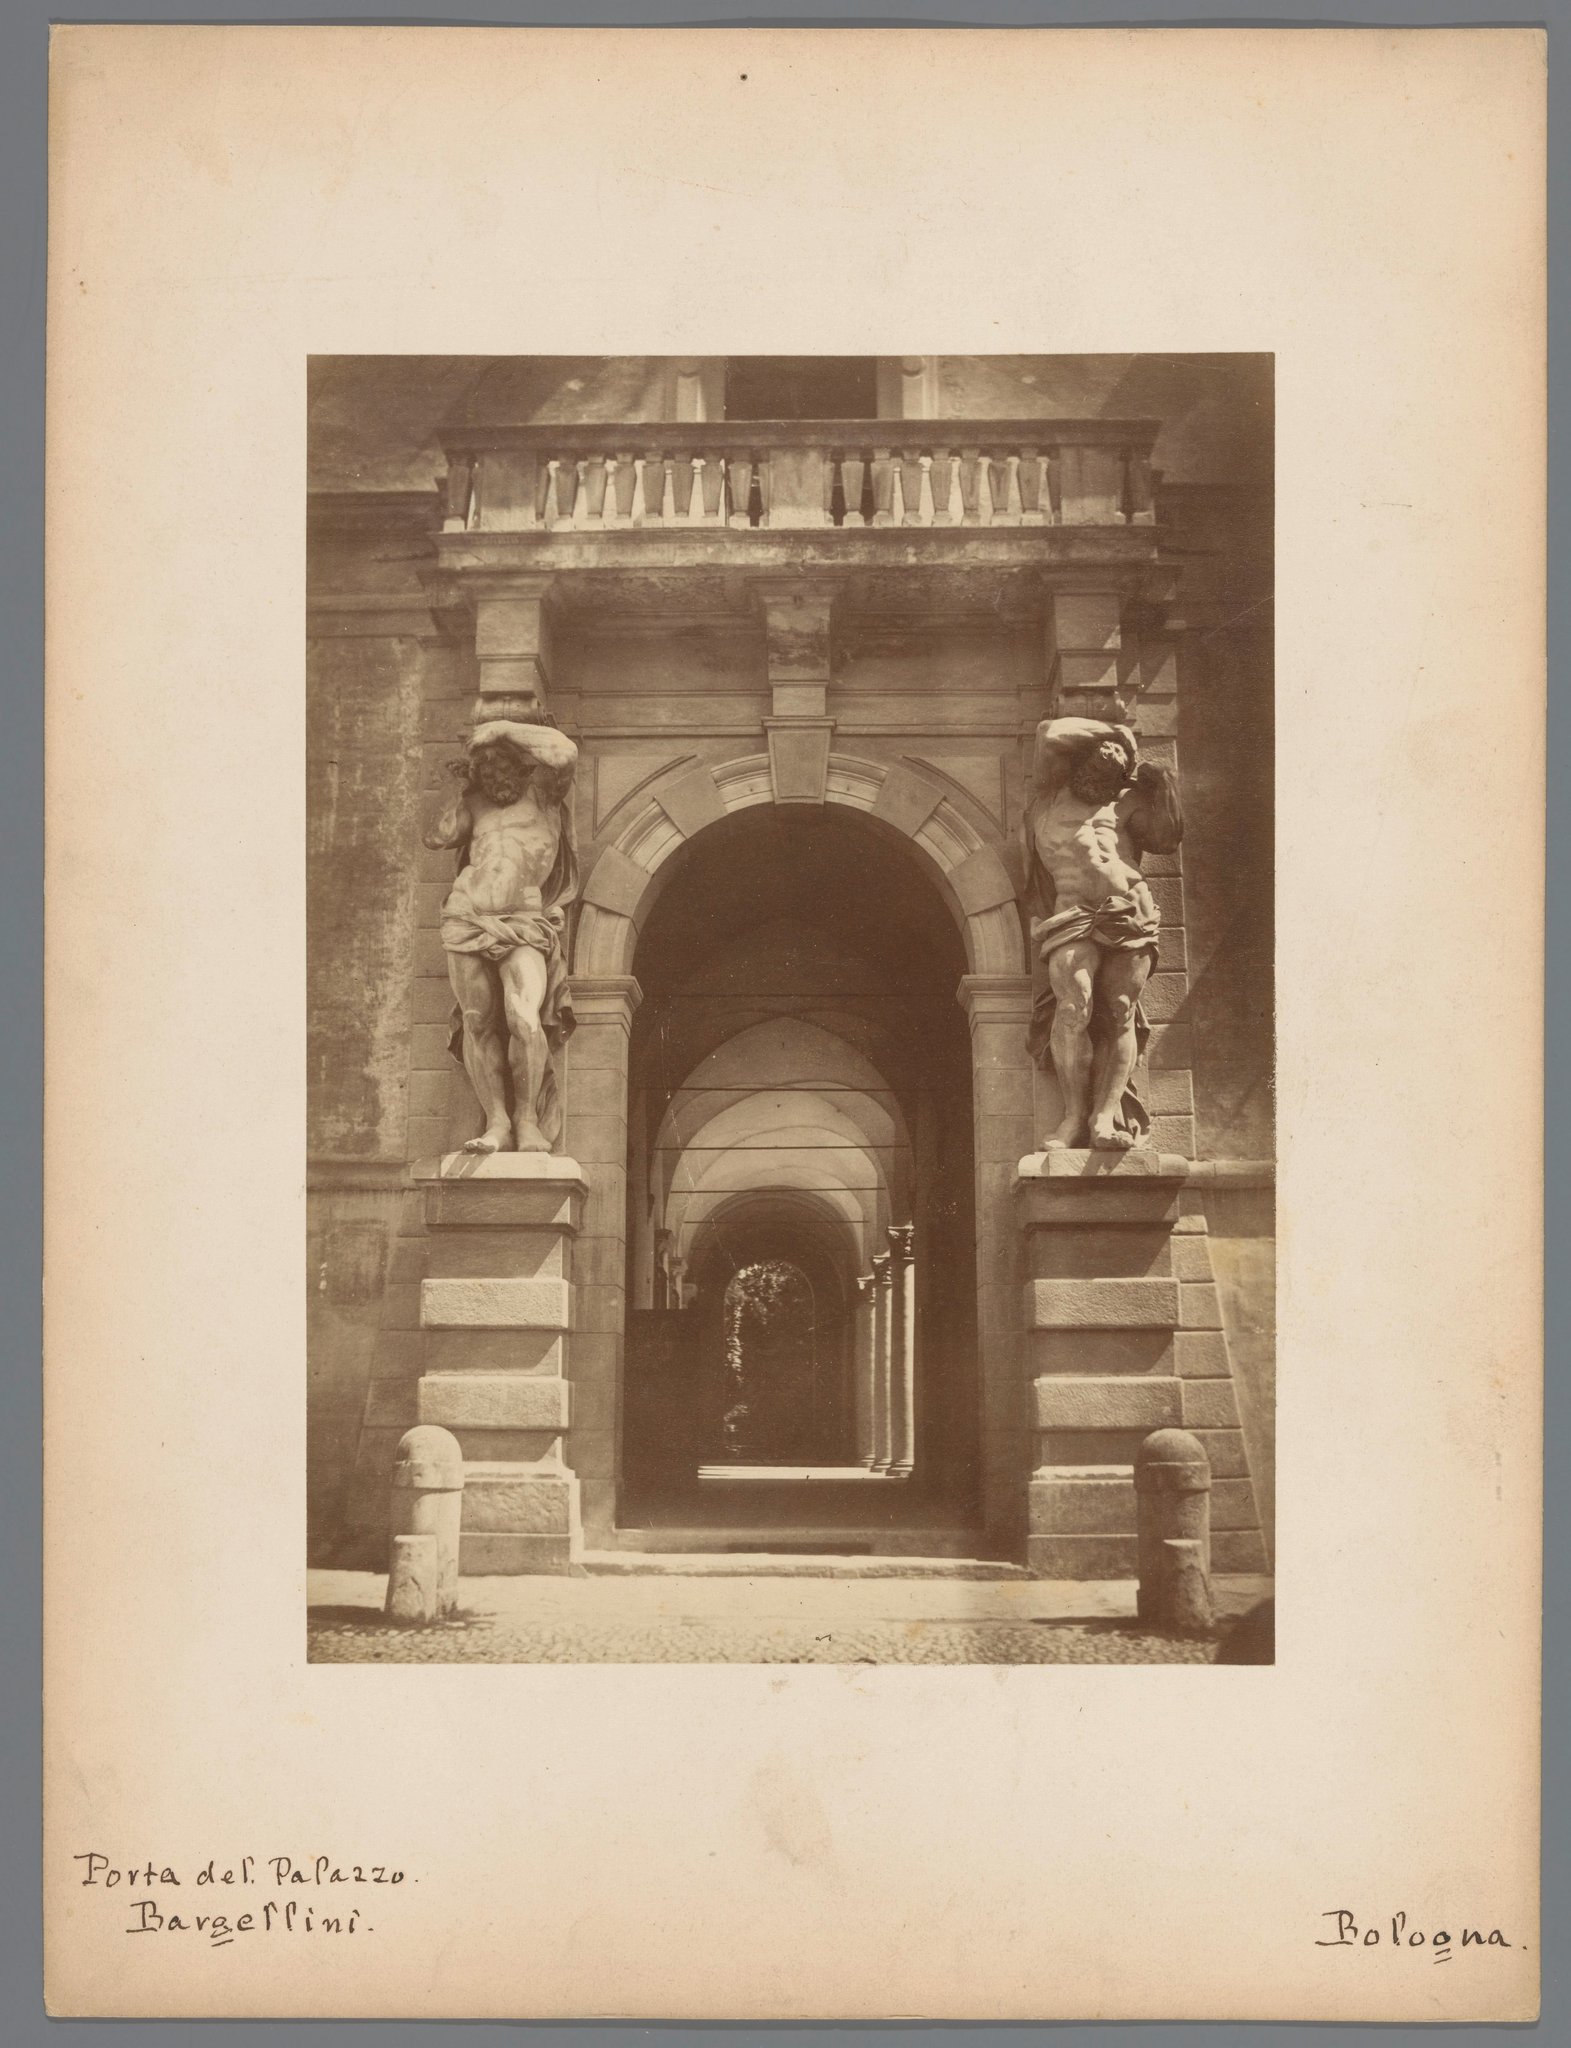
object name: photograph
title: Porta del.'Palazzo. Bargellini. Bologna.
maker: Anonymous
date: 1875-1900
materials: cardboard, photographic support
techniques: albumen print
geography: bologna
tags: gate, entrance, balcony, sculpture (+ relief ~ sculpture)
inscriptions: collector's mark: Lugt 3937